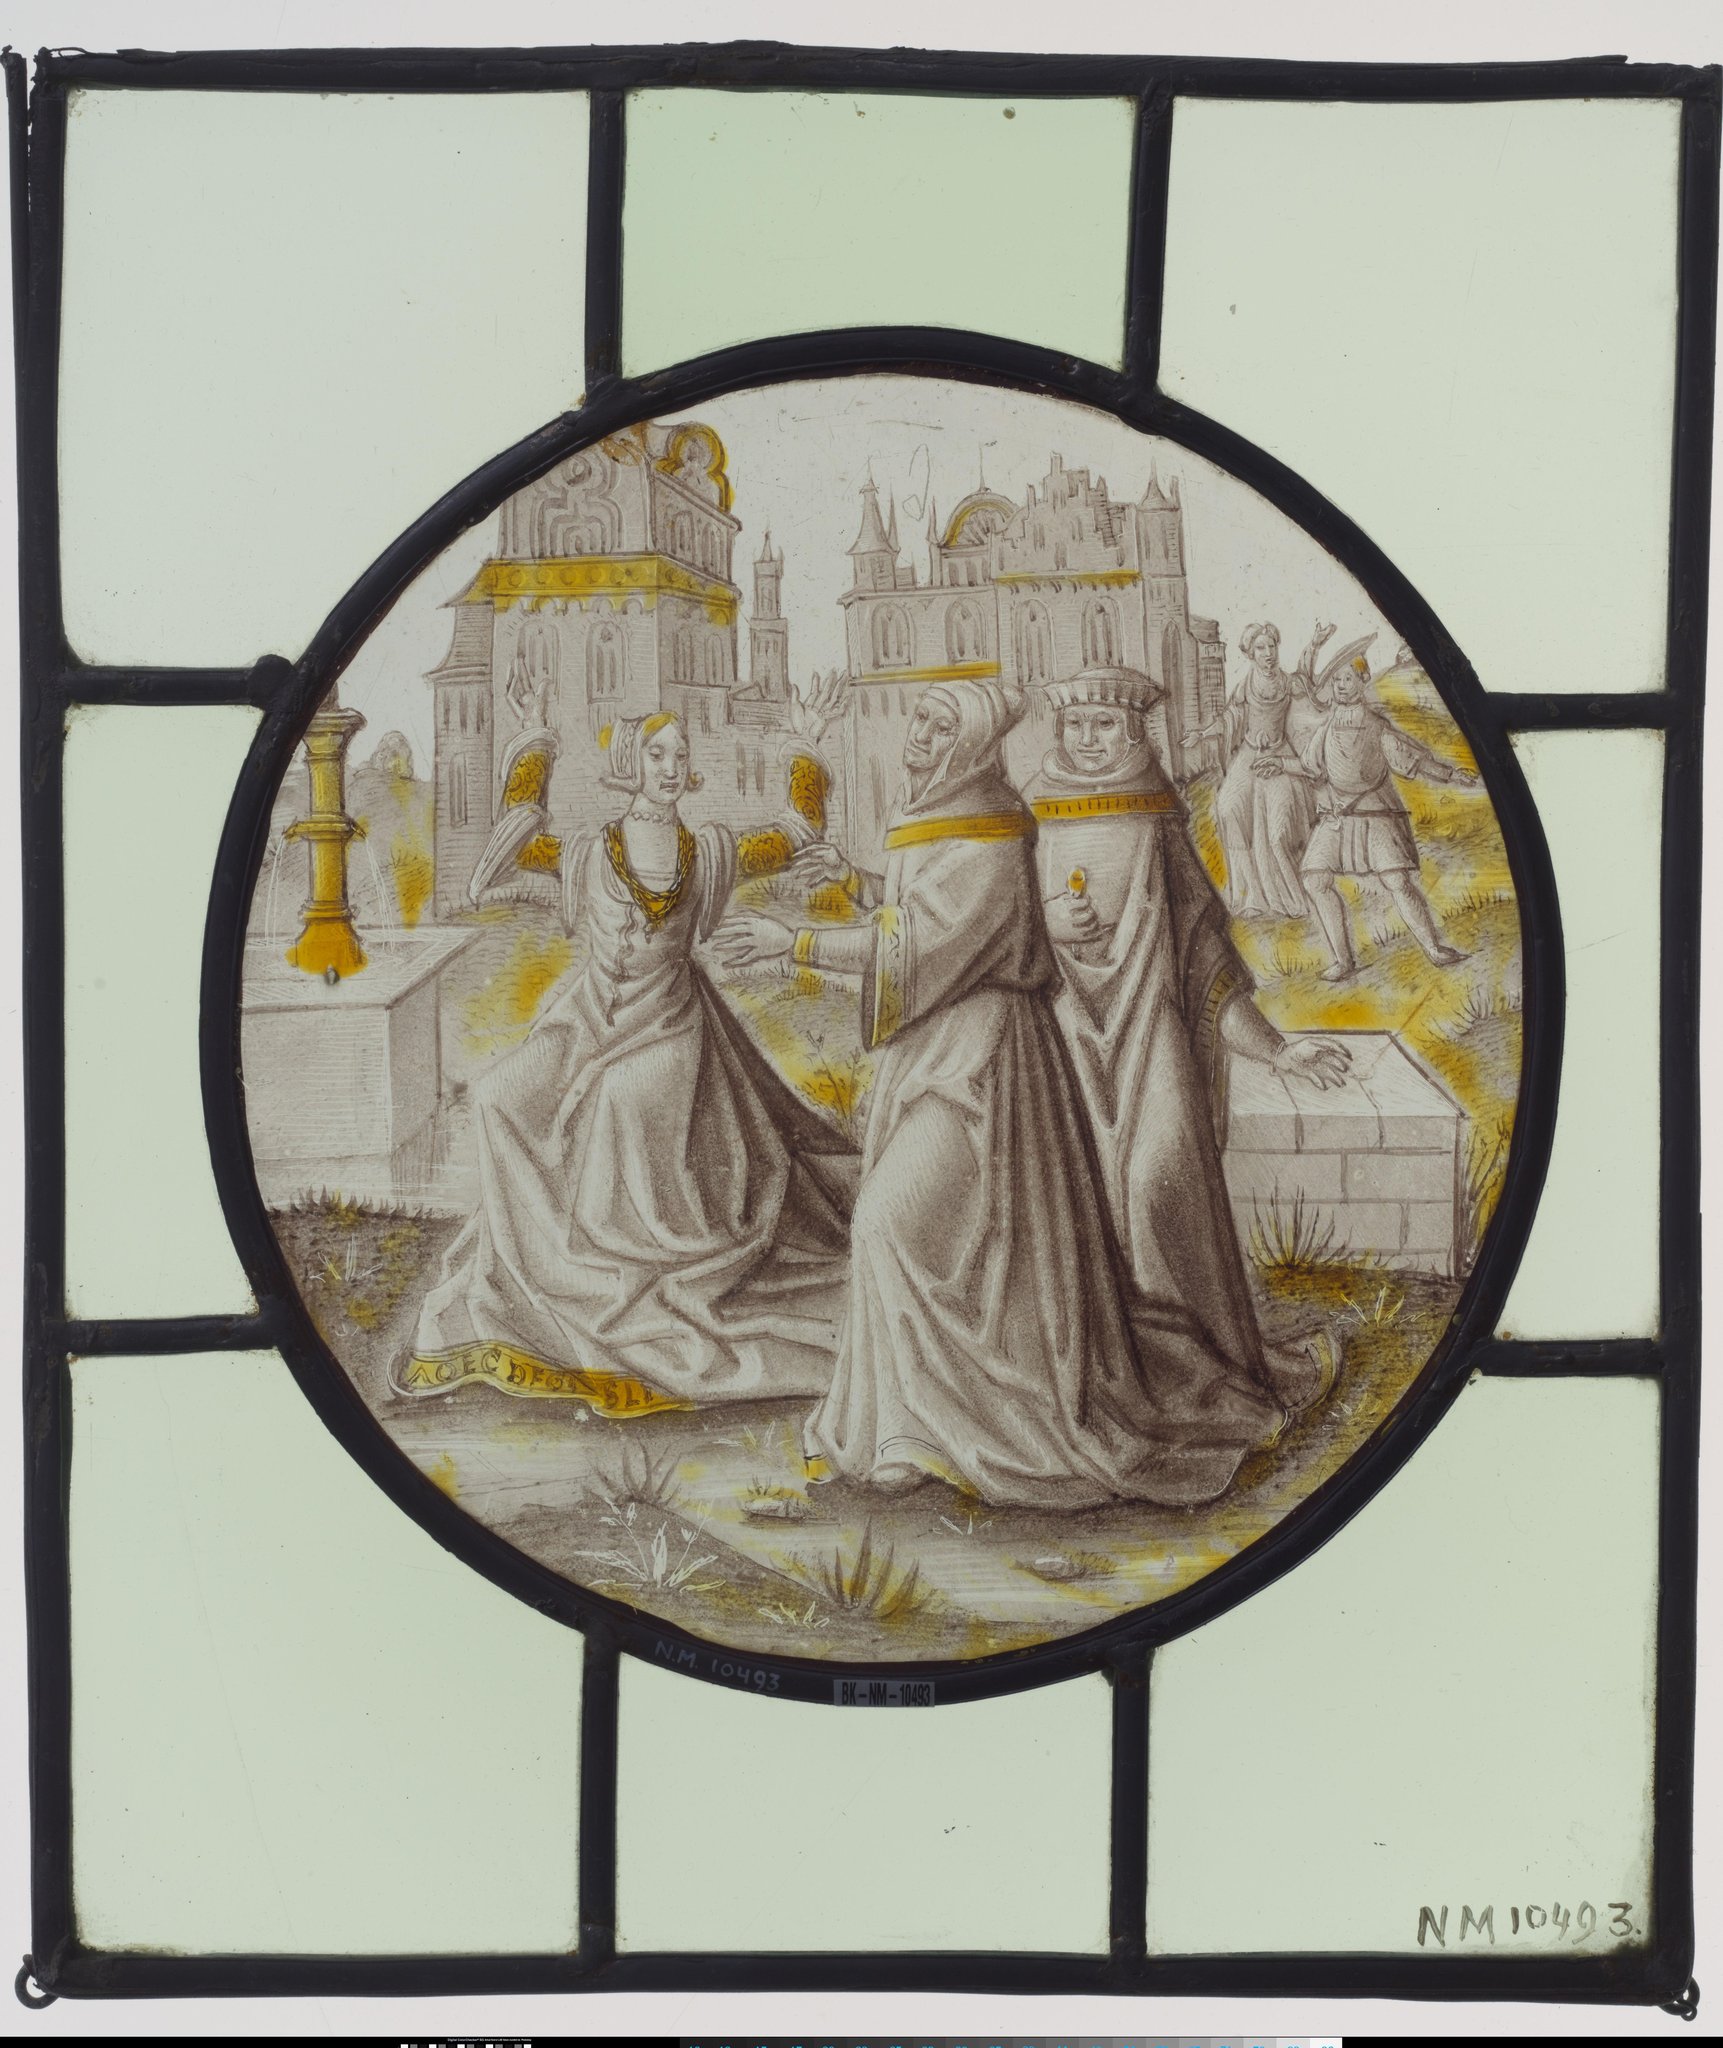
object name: light window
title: Ruit met Susanna en de oude mannen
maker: Anonymous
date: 1525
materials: glass, lead, pigment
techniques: leading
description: Een rond gebrande ruit met de voorstelling van de kuise Suzanna door de Ouden gegrepen. Op de achtergrond twee te hulp aansnellende figuren en enkele gebouwen.